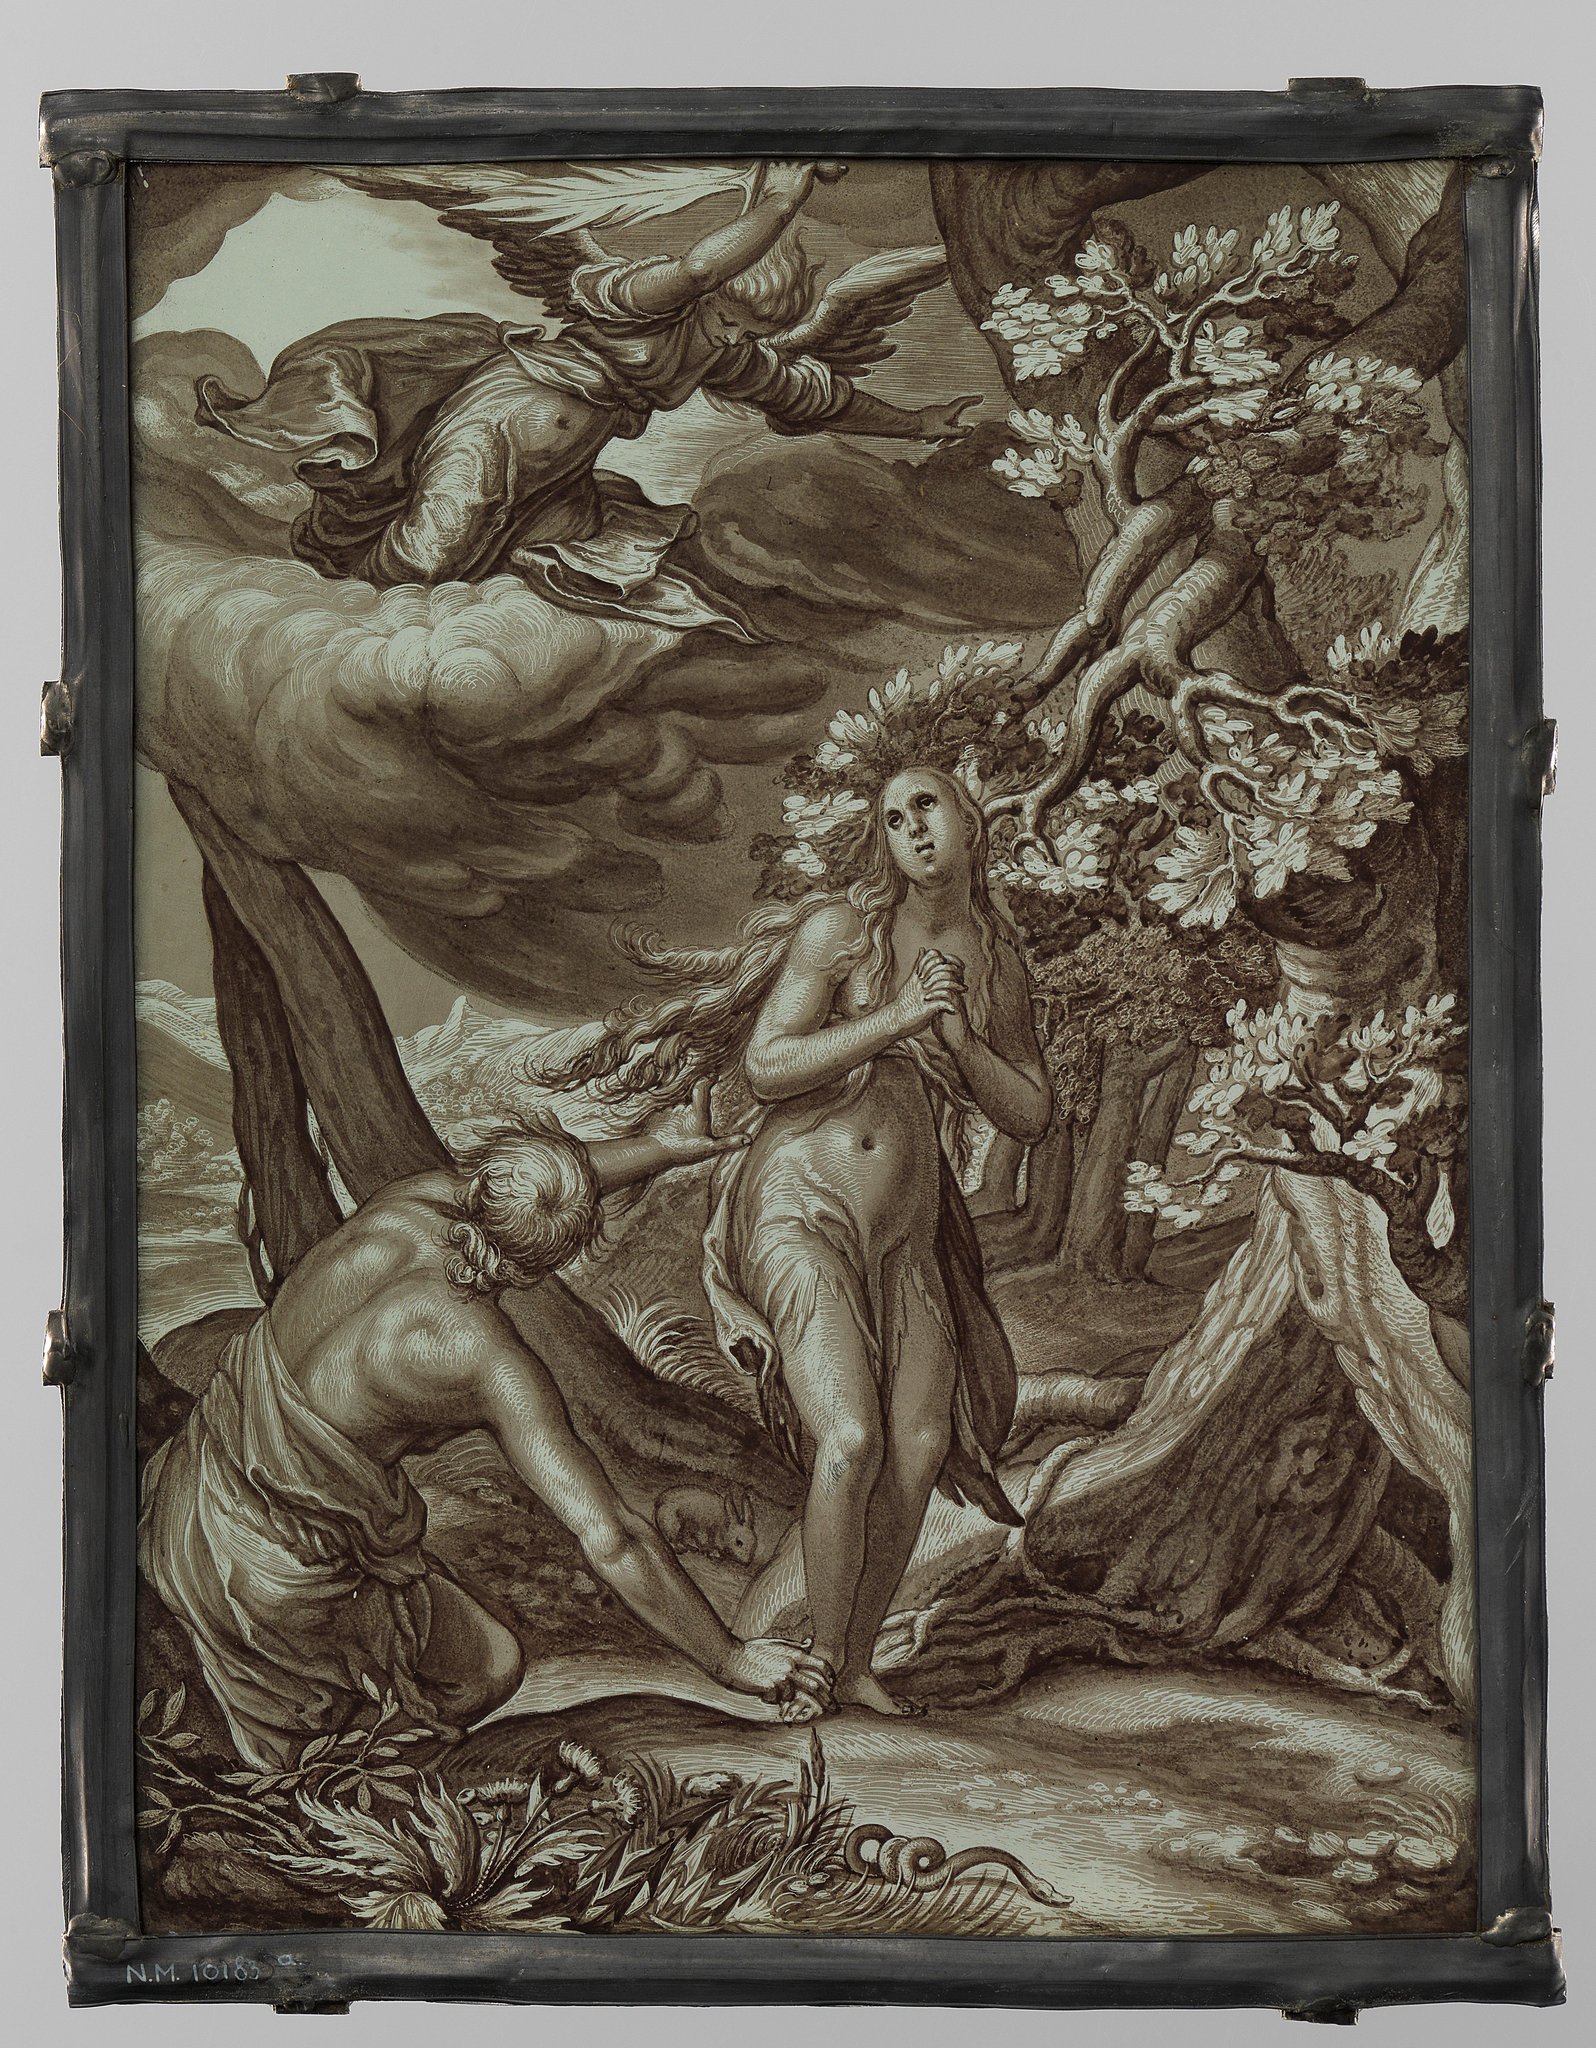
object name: light window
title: Ruit met de verdrijving uit het paradijs van Adam en Eva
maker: Anonymous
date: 1600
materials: glass, lead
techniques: leading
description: Rechthoekige gebrandschilderde ruit "en grisaille" waarop afgebeeld "Adam en Eva na de val door de uit de wolken dalende engel uit het paradijs gejaagd.